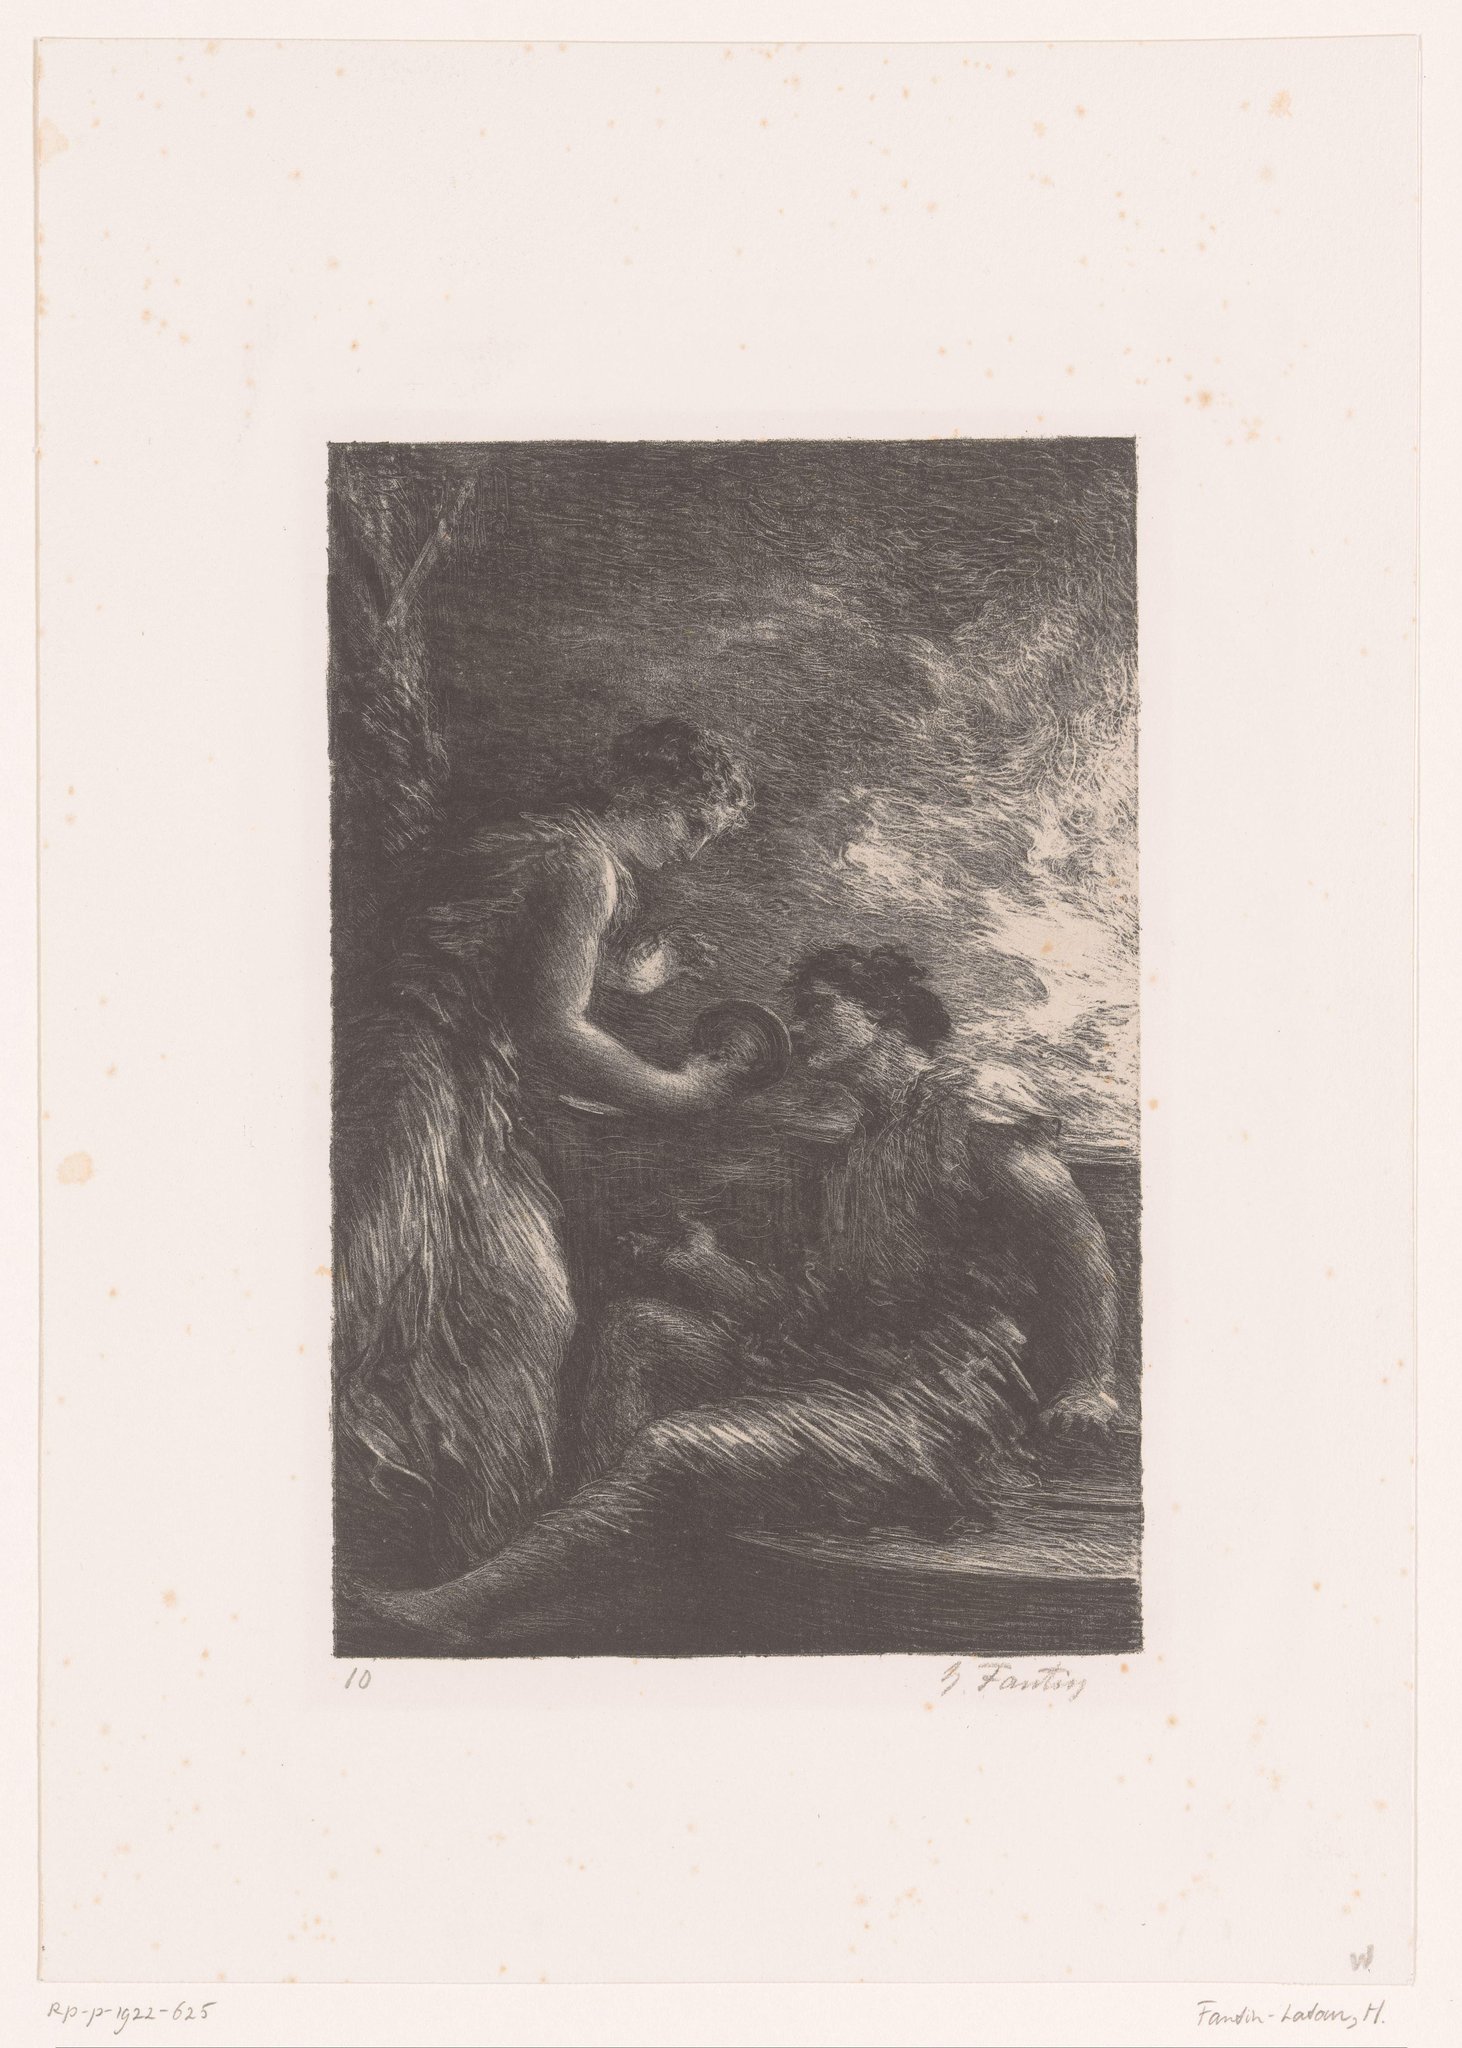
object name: book illustration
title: Leven en werken van Richard Wagner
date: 1886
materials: paper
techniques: lithography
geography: paris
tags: 'nibelungenlied', giving drink, opera, brothers or sisters (second degree family relationships)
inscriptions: collector's mark: Lugt 2228a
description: Prent gebruikt voor: A. Jullien, Richard Wagner: sa vie et ses œuvres, Parijs 1886. Scène uit Wagners opera Die Walküre (akte 1).